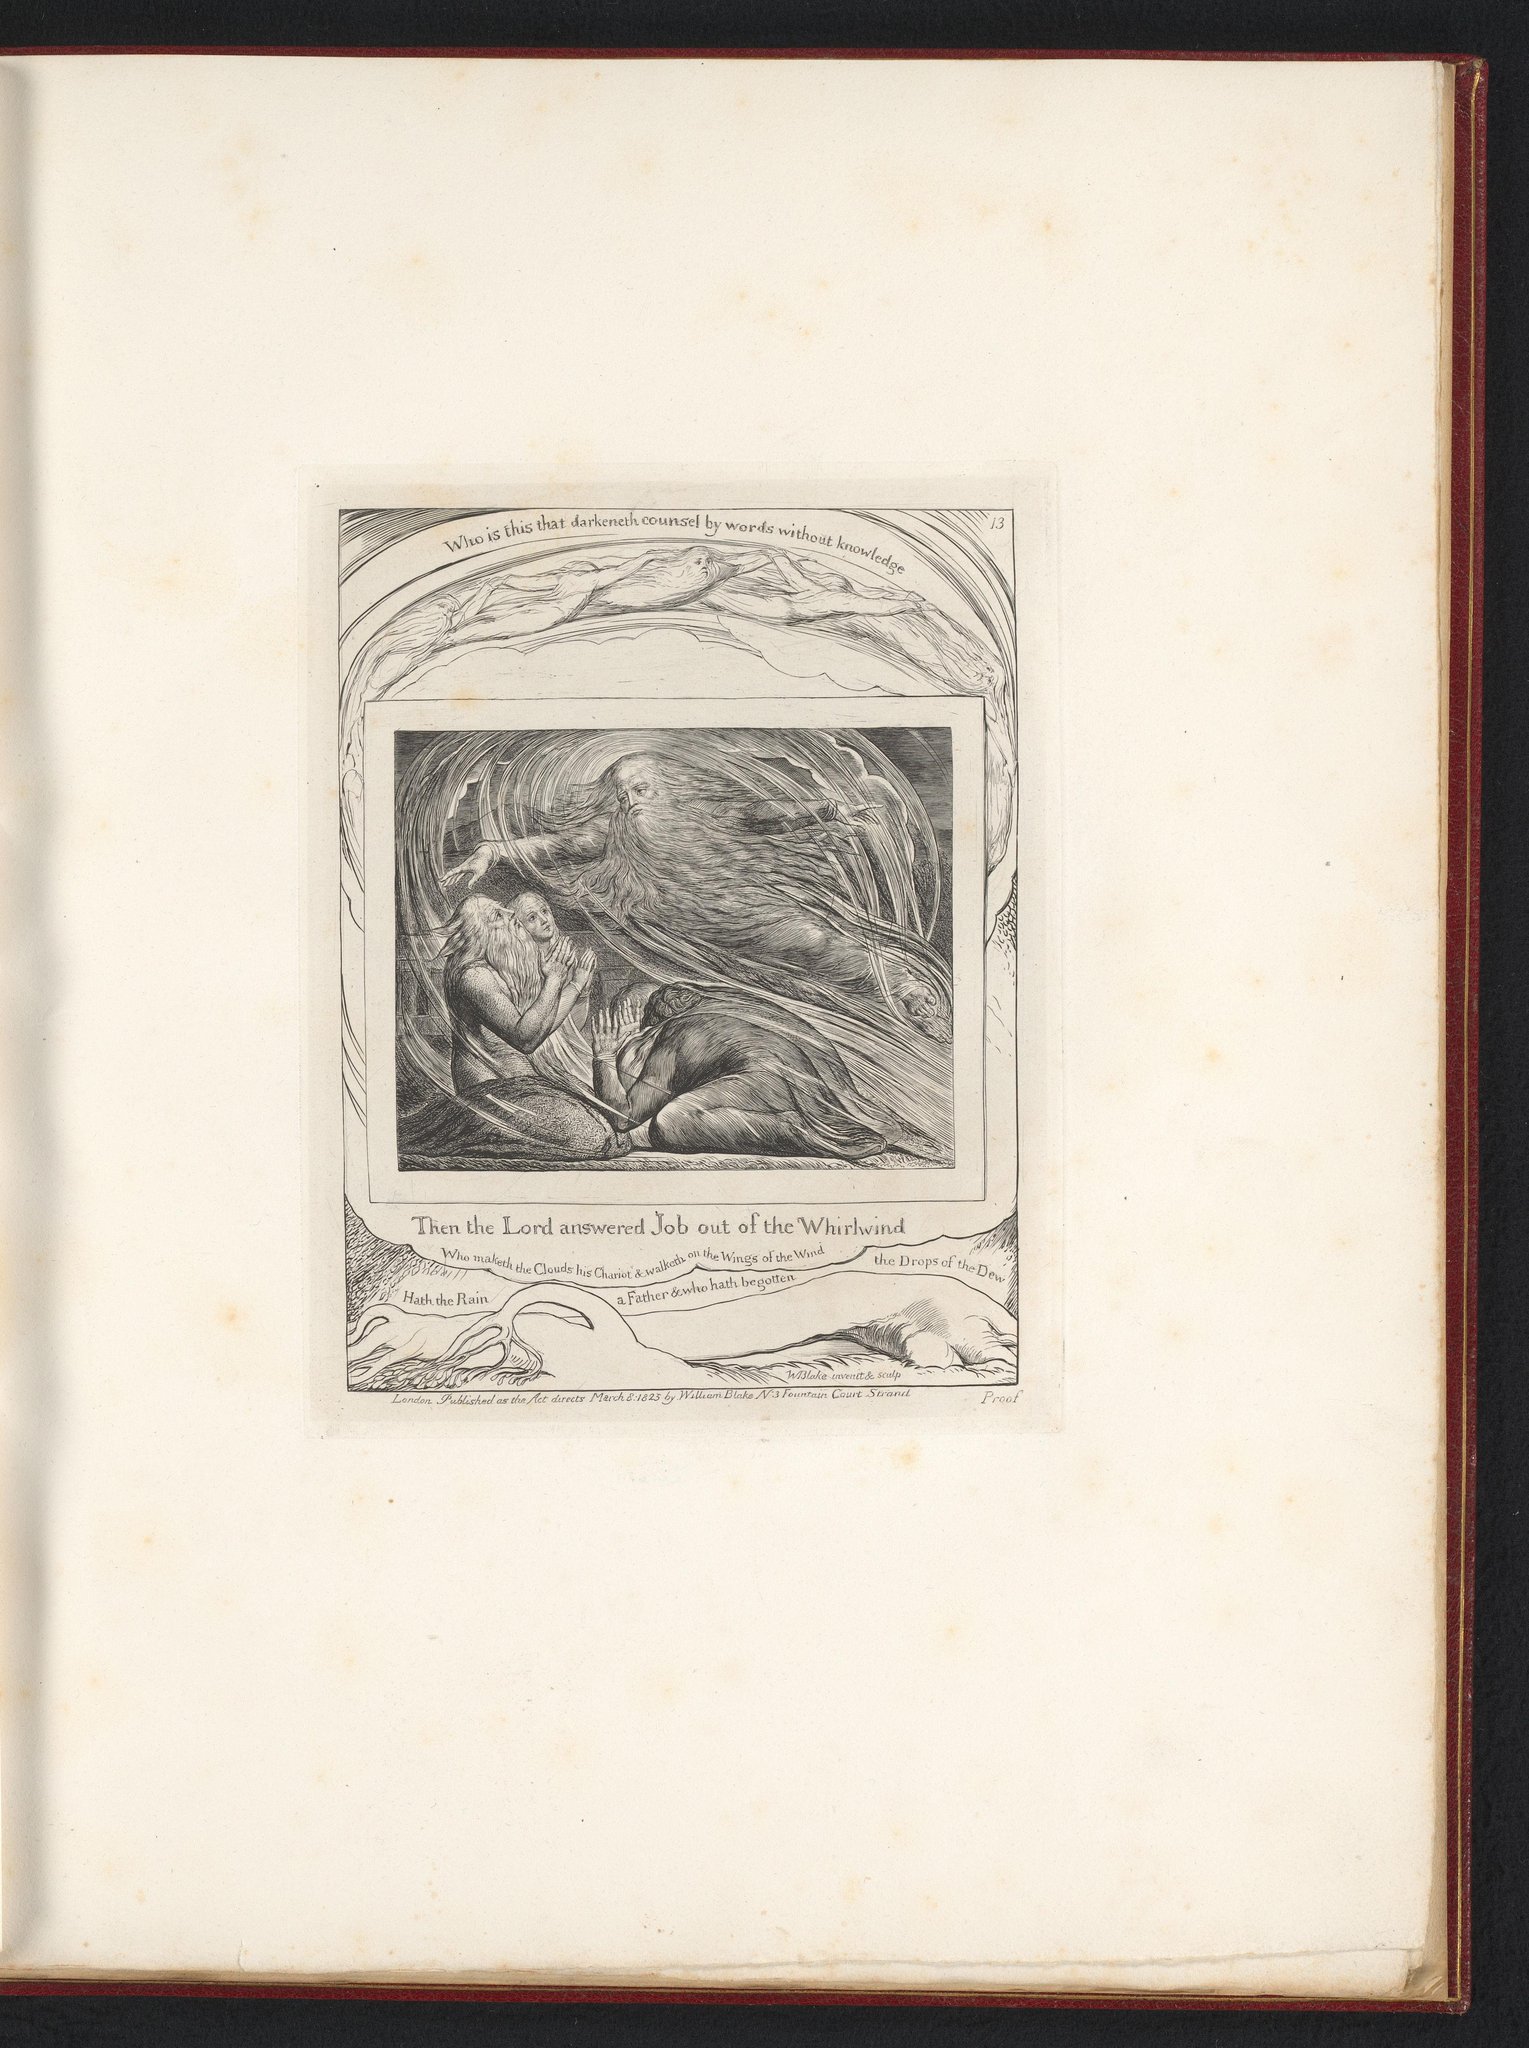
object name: print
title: Then the Lord answered Job out of the Whirlwind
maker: william blake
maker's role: print maker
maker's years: 1757-1827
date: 1825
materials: paper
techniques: engraving, etching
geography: london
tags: god speaks to job from out of the whirlwind (job 38 - 42:6)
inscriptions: collector's mark: Lugt 2228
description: Prent maakt deel uit van een serie van 21 prenten. Er bestaan 150 afdrukken van de serie met daarop 'proof'.